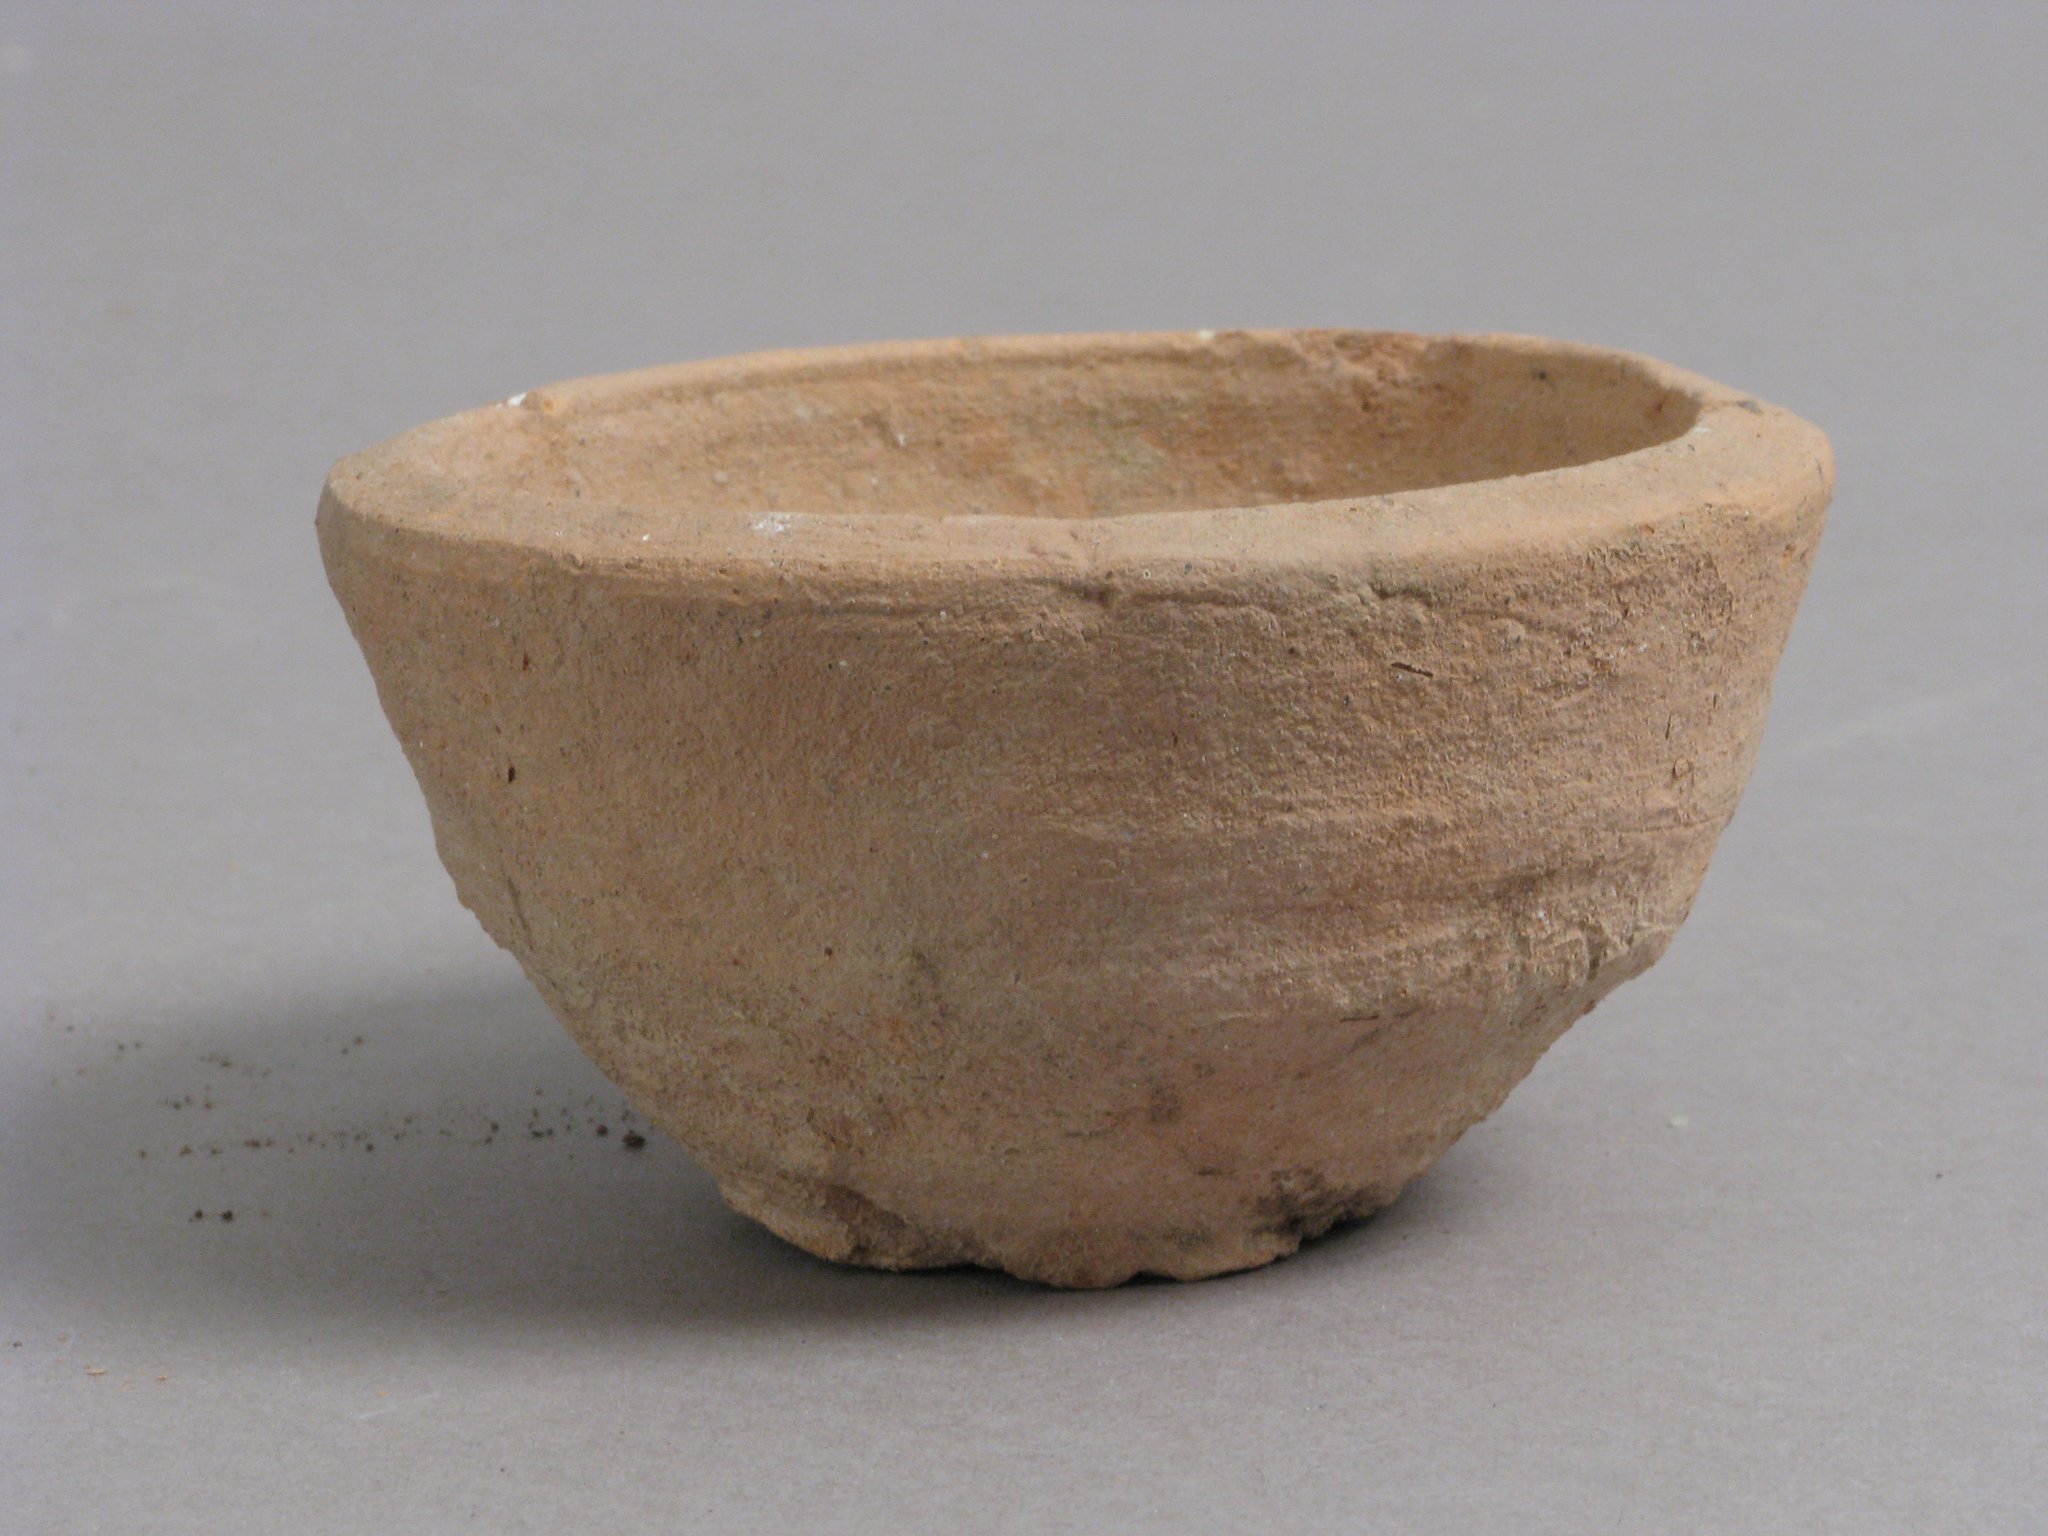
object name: bowl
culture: coptic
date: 301-700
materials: earthenware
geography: egypt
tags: bowls